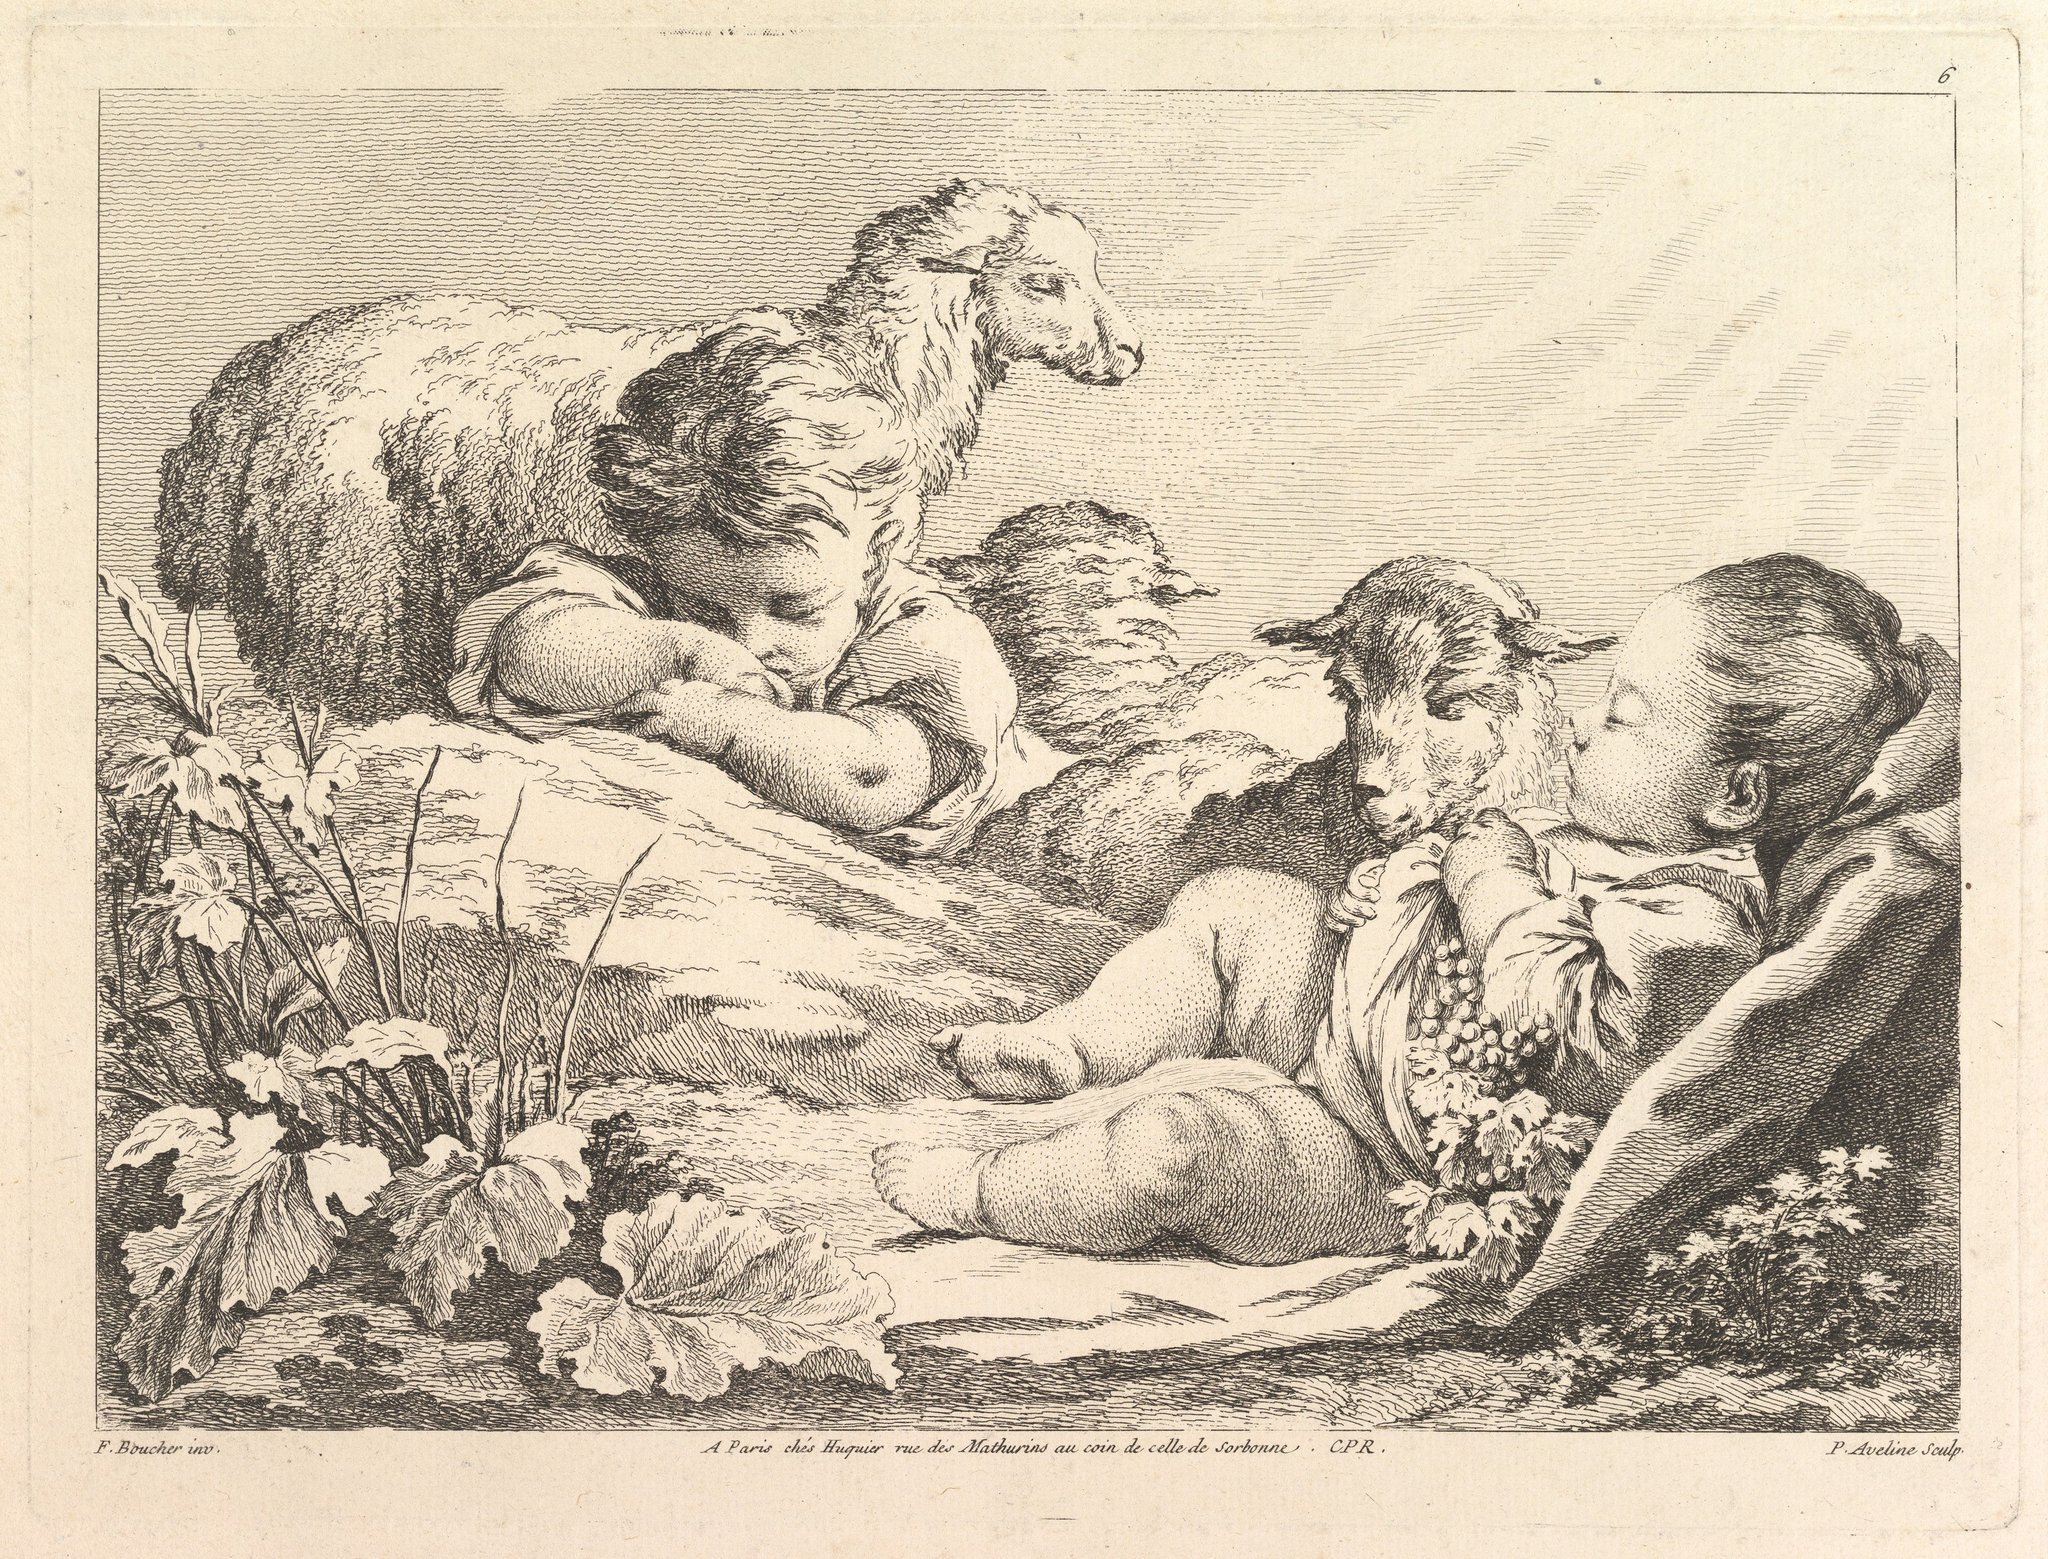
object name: print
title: Two Sleeping Children With Three Sheep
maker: pierre alexandre aveline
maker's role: artist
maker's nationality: french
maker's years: 1702-1760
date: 1701-1800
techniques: engraving, etching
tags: sleeping,children,sheep